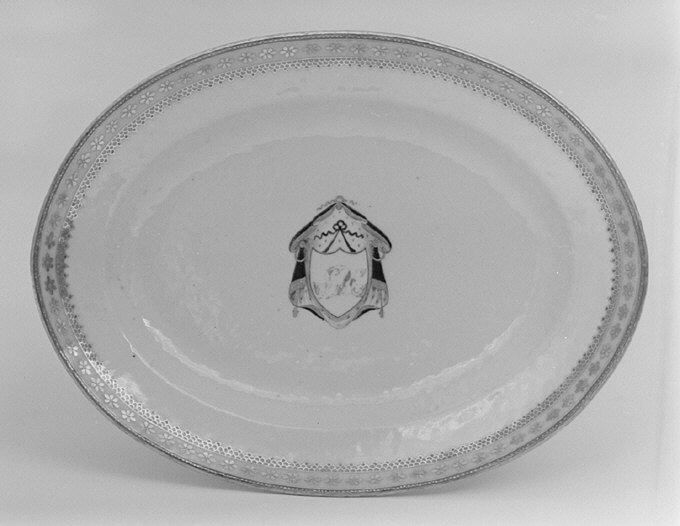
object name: platter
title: Platter (part of a service)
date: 1790-1800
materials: hard paste porcelain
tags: coat of arms